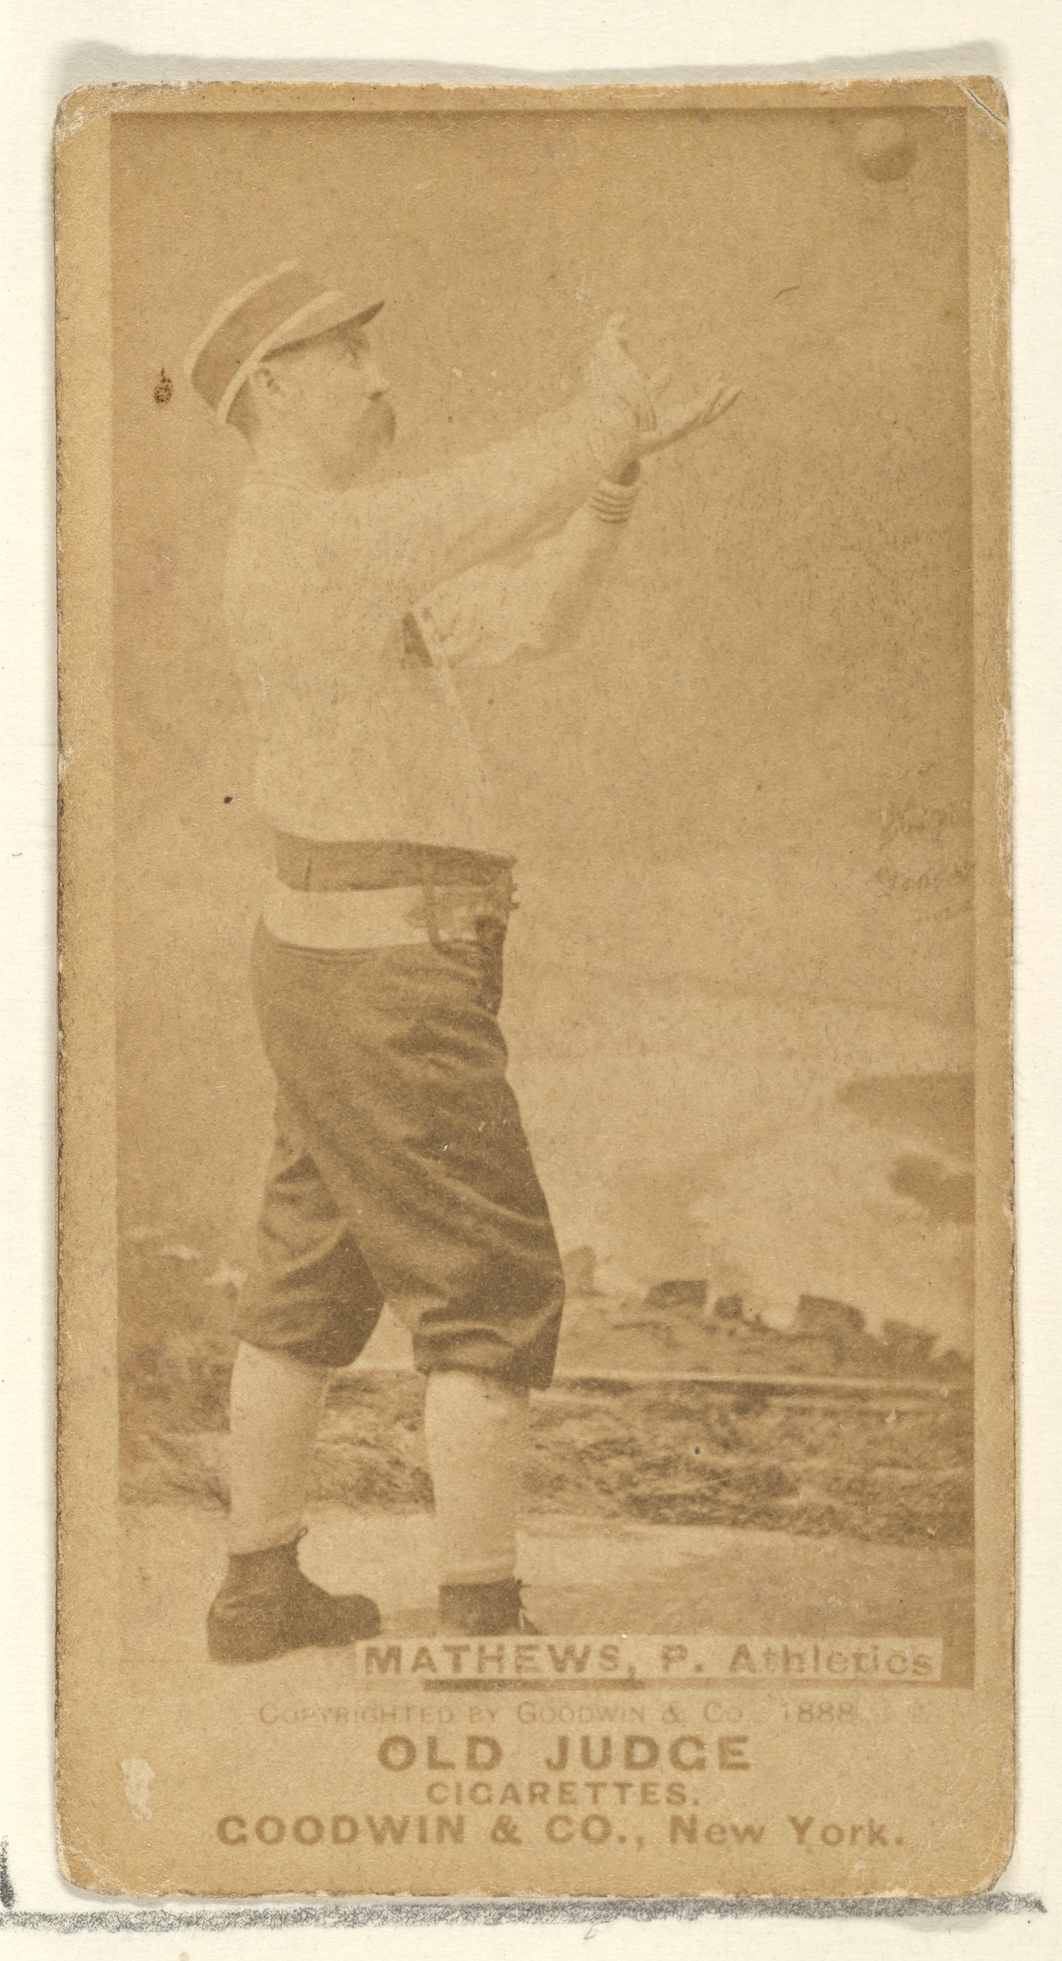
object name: baseball card, photograph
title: Mathews, Pitcher, Philadelphia Athletics, from the Old Judge series (N172) for Old Judge Cigarettes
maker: goodwin & company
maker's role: publisher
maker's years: 1850-1950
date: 1888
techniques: albumen silver print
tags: men,portraits,baseball,athletes